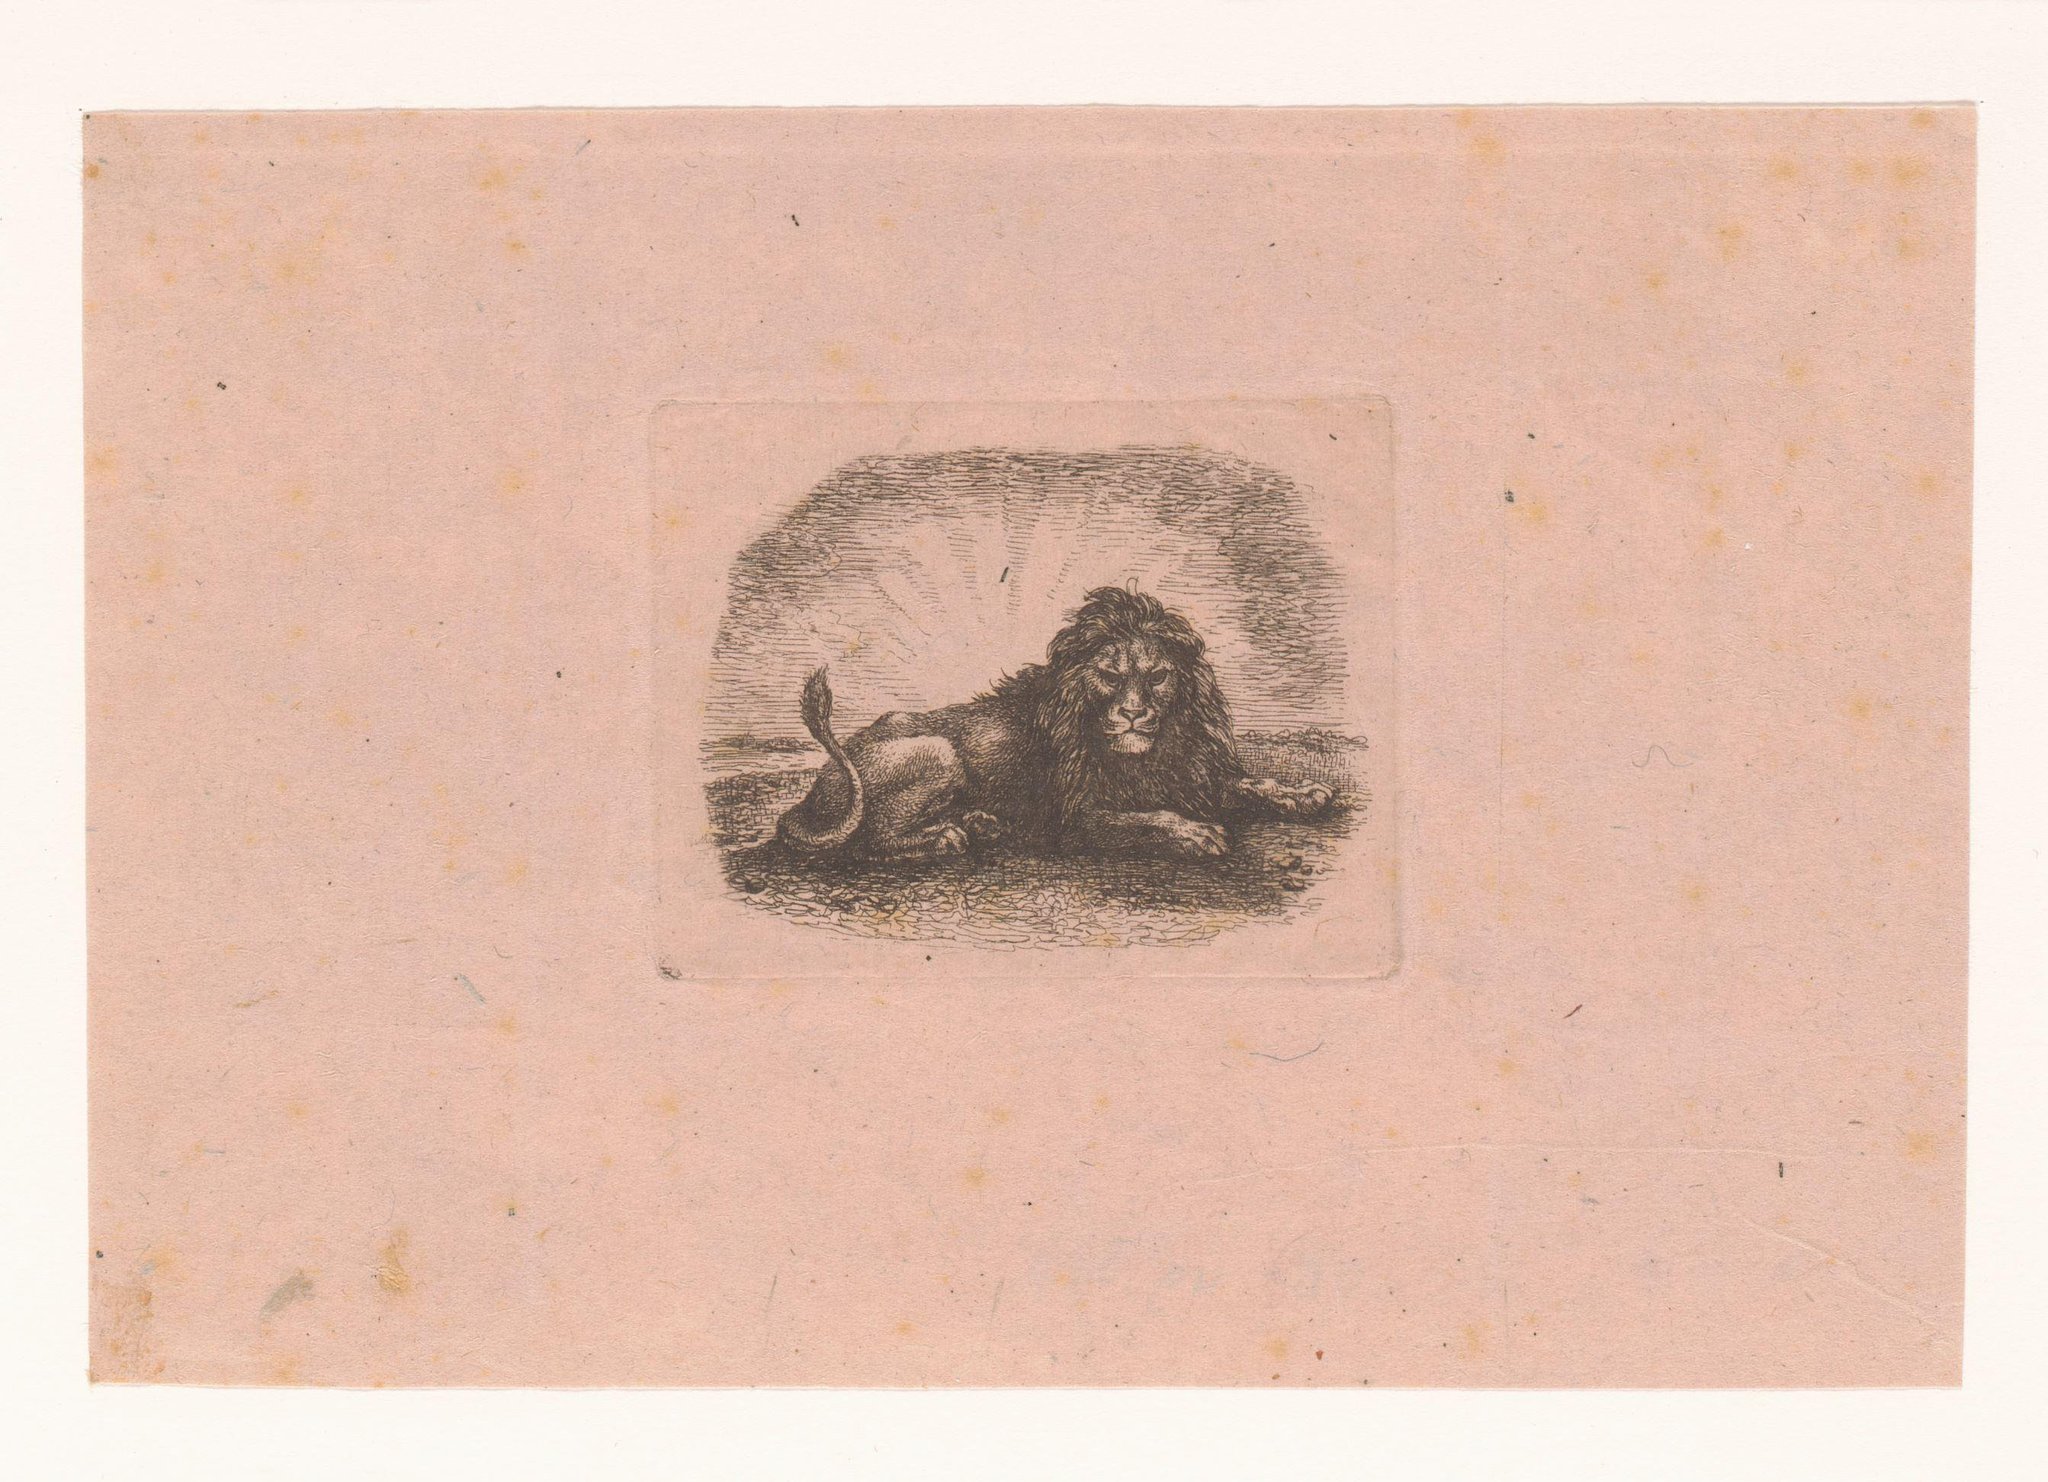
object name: print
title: Liggende leeuw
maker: eugène verboeckhoven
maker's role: draughtsman, painter, print maker, printer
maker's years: 1798-1881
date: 1828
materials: paper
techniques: etching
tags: beasts of prey, predatory animals: lion